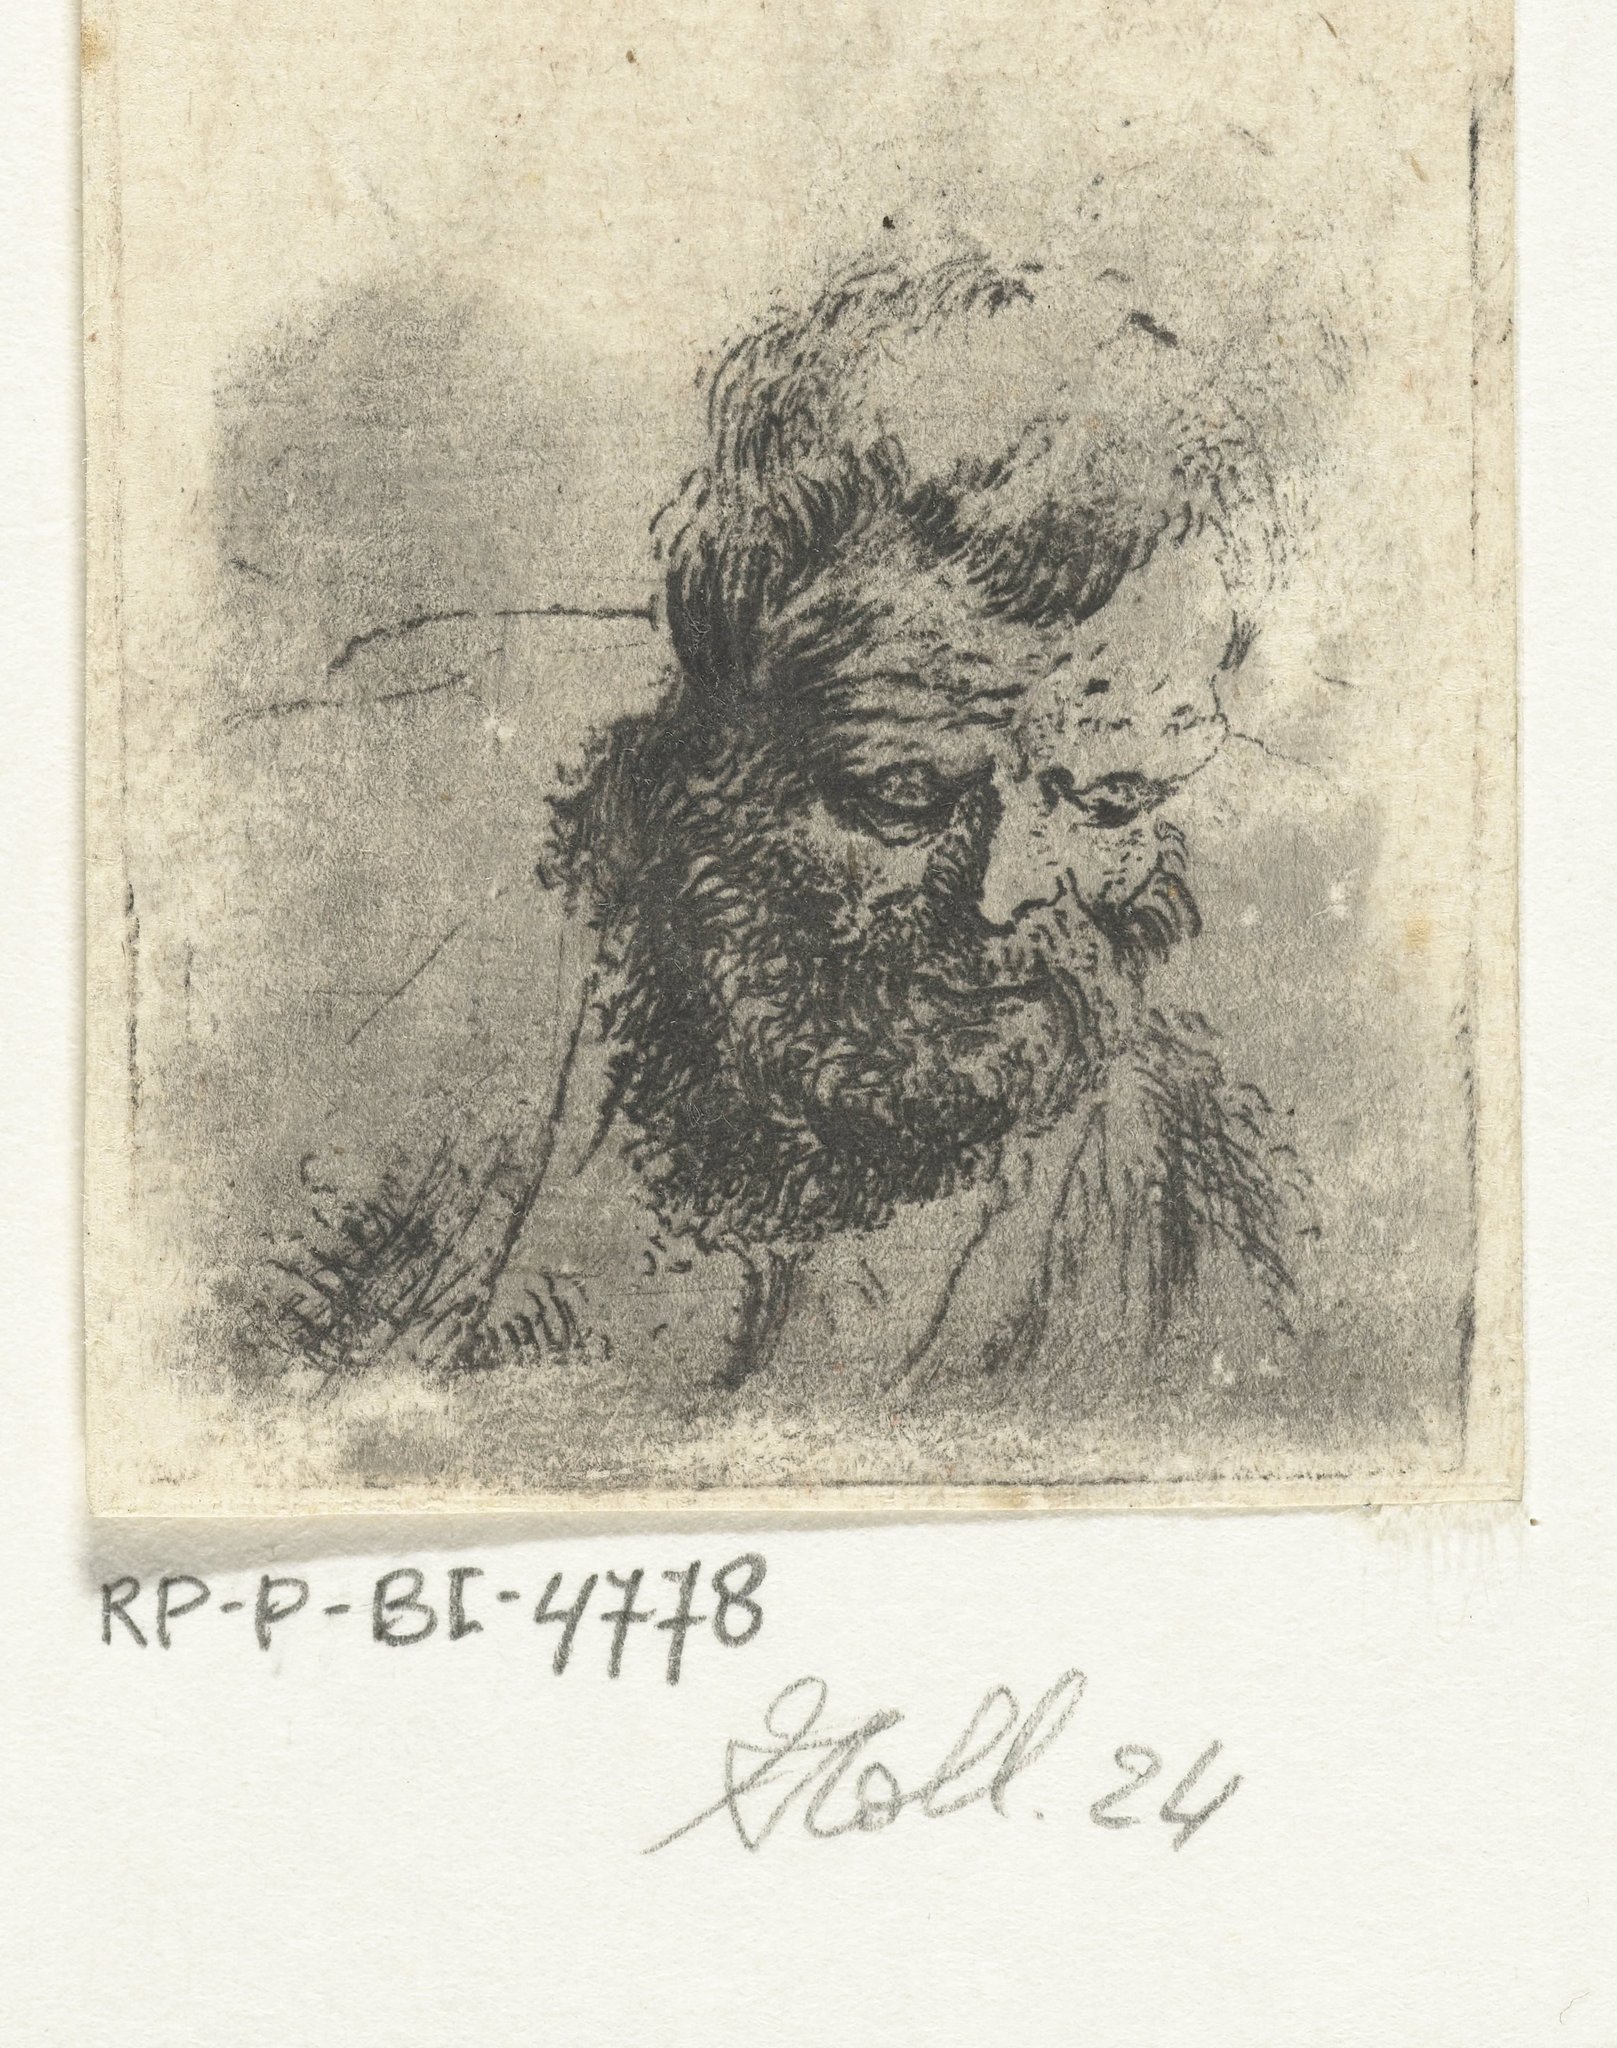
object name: print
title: Hoofd van oude man met baard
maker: dirck de bray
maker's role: draughtsman, painter, print maker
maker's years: 1625-1694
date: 1645-1694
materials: paper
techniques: etching, intaglio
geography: netherlands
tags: old man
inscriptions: collector's mark: Lugt 240